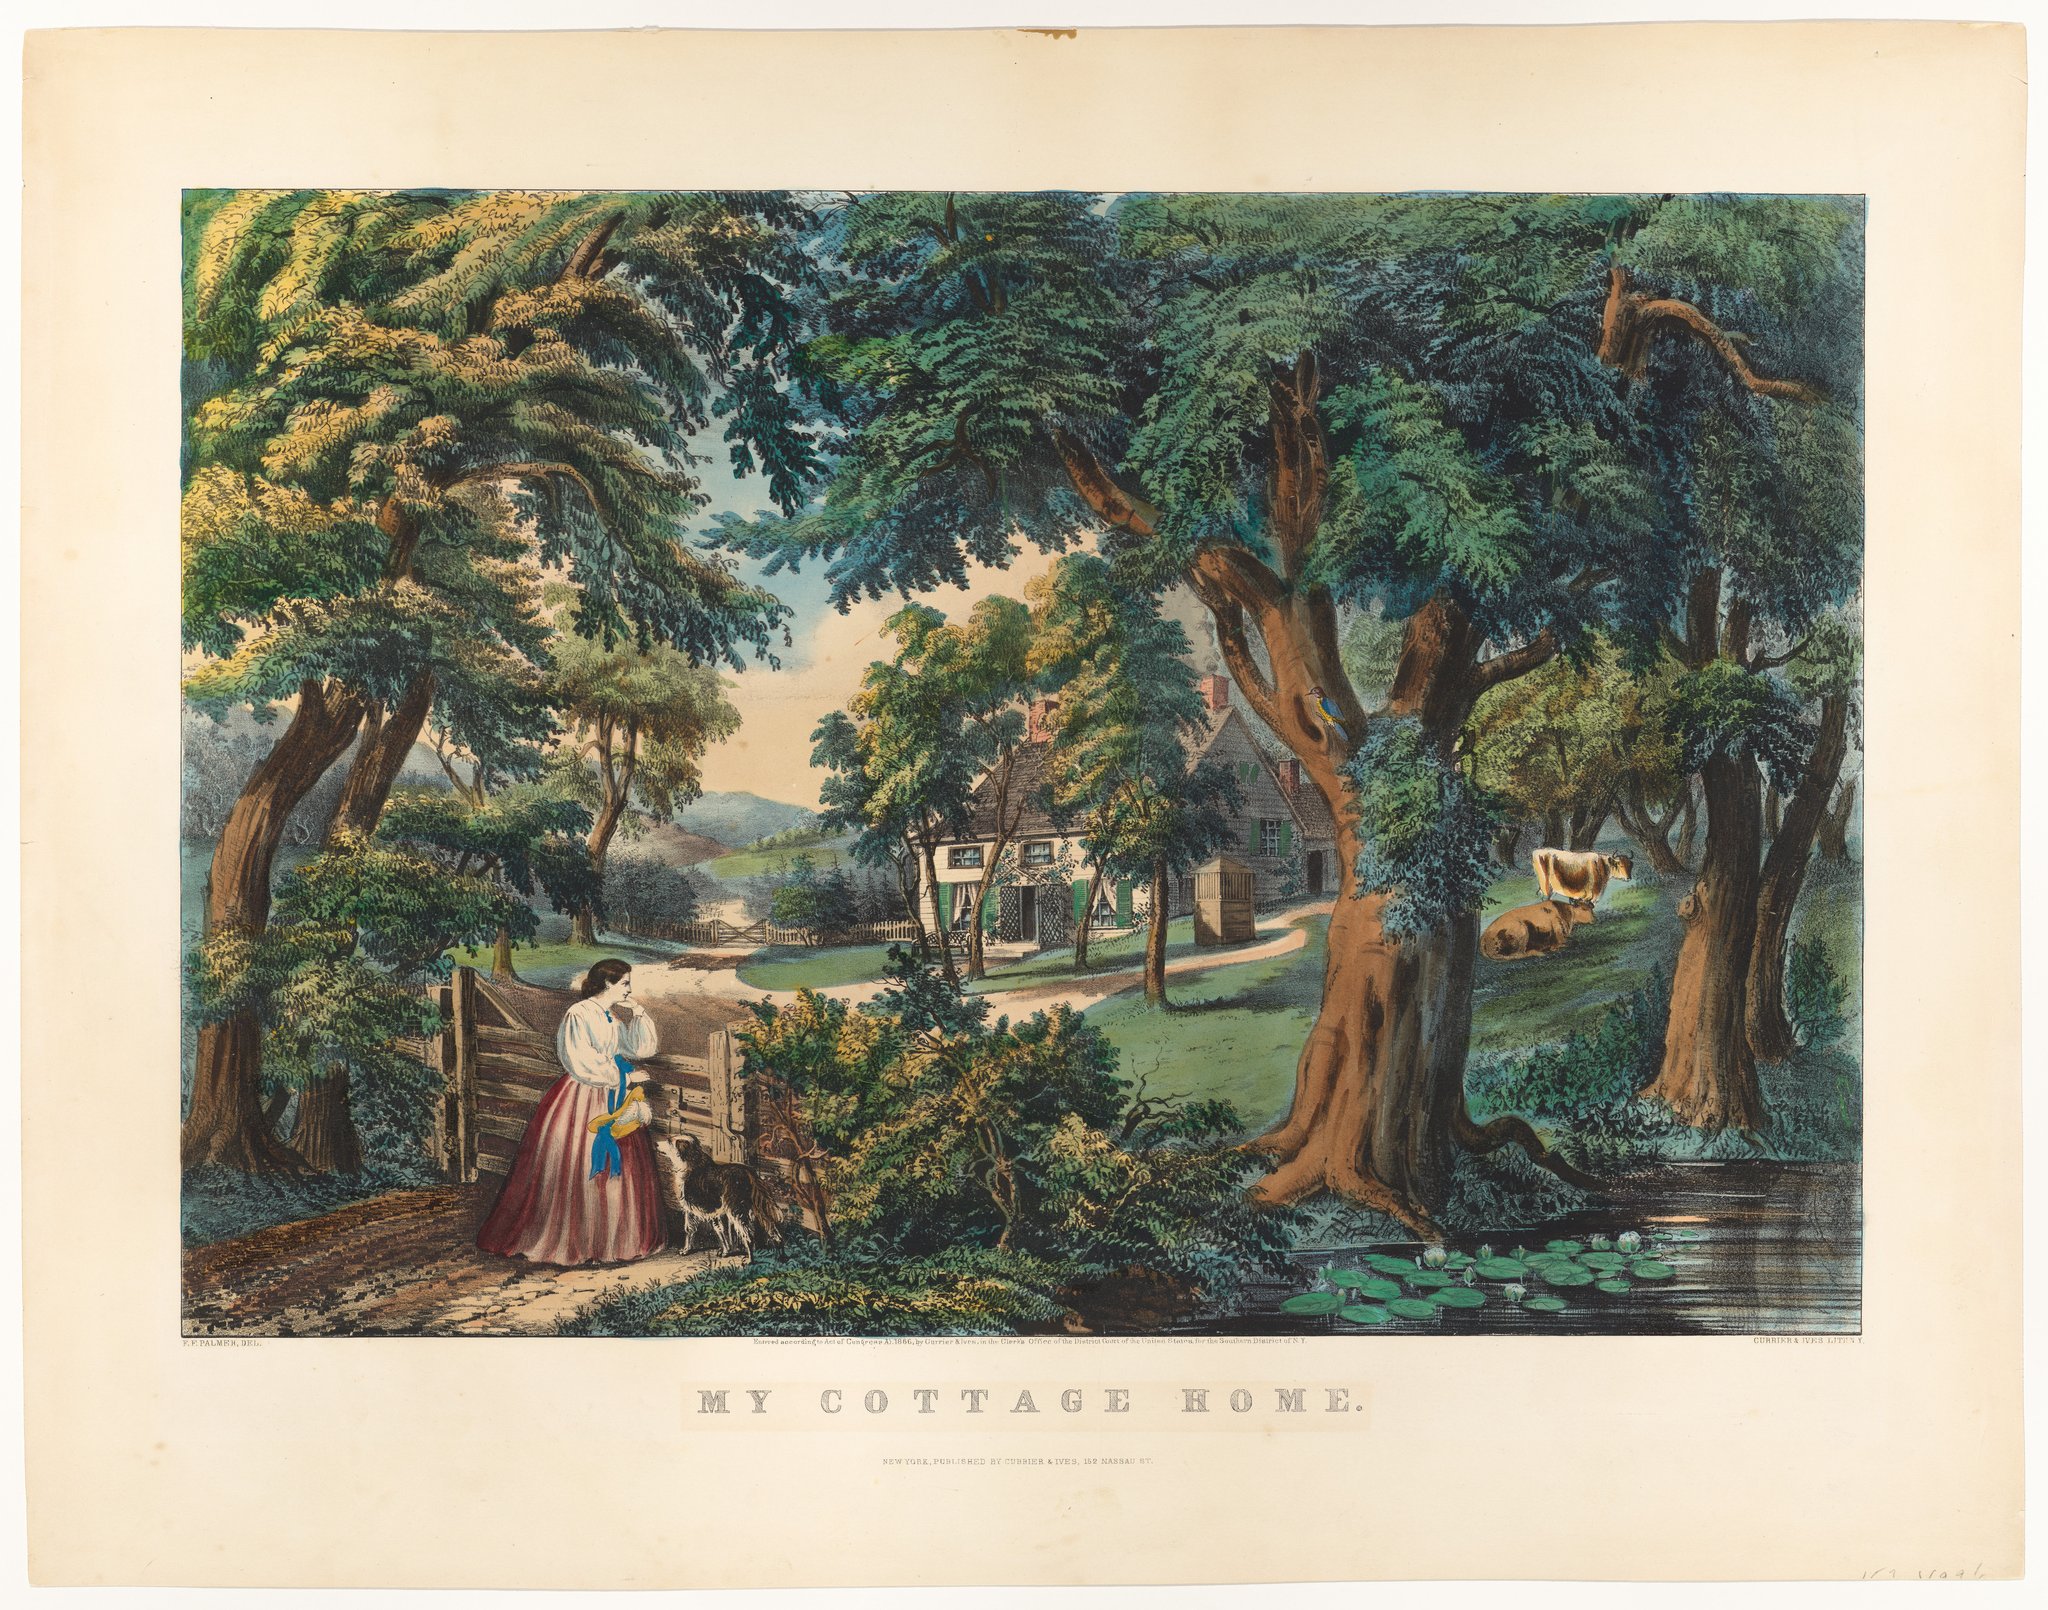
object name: print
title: My Cottage Home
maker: frances flora bond palmer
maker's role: artist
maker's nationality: american, born england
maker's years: 1812-1876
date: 1866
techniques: hand coloring, lithograph